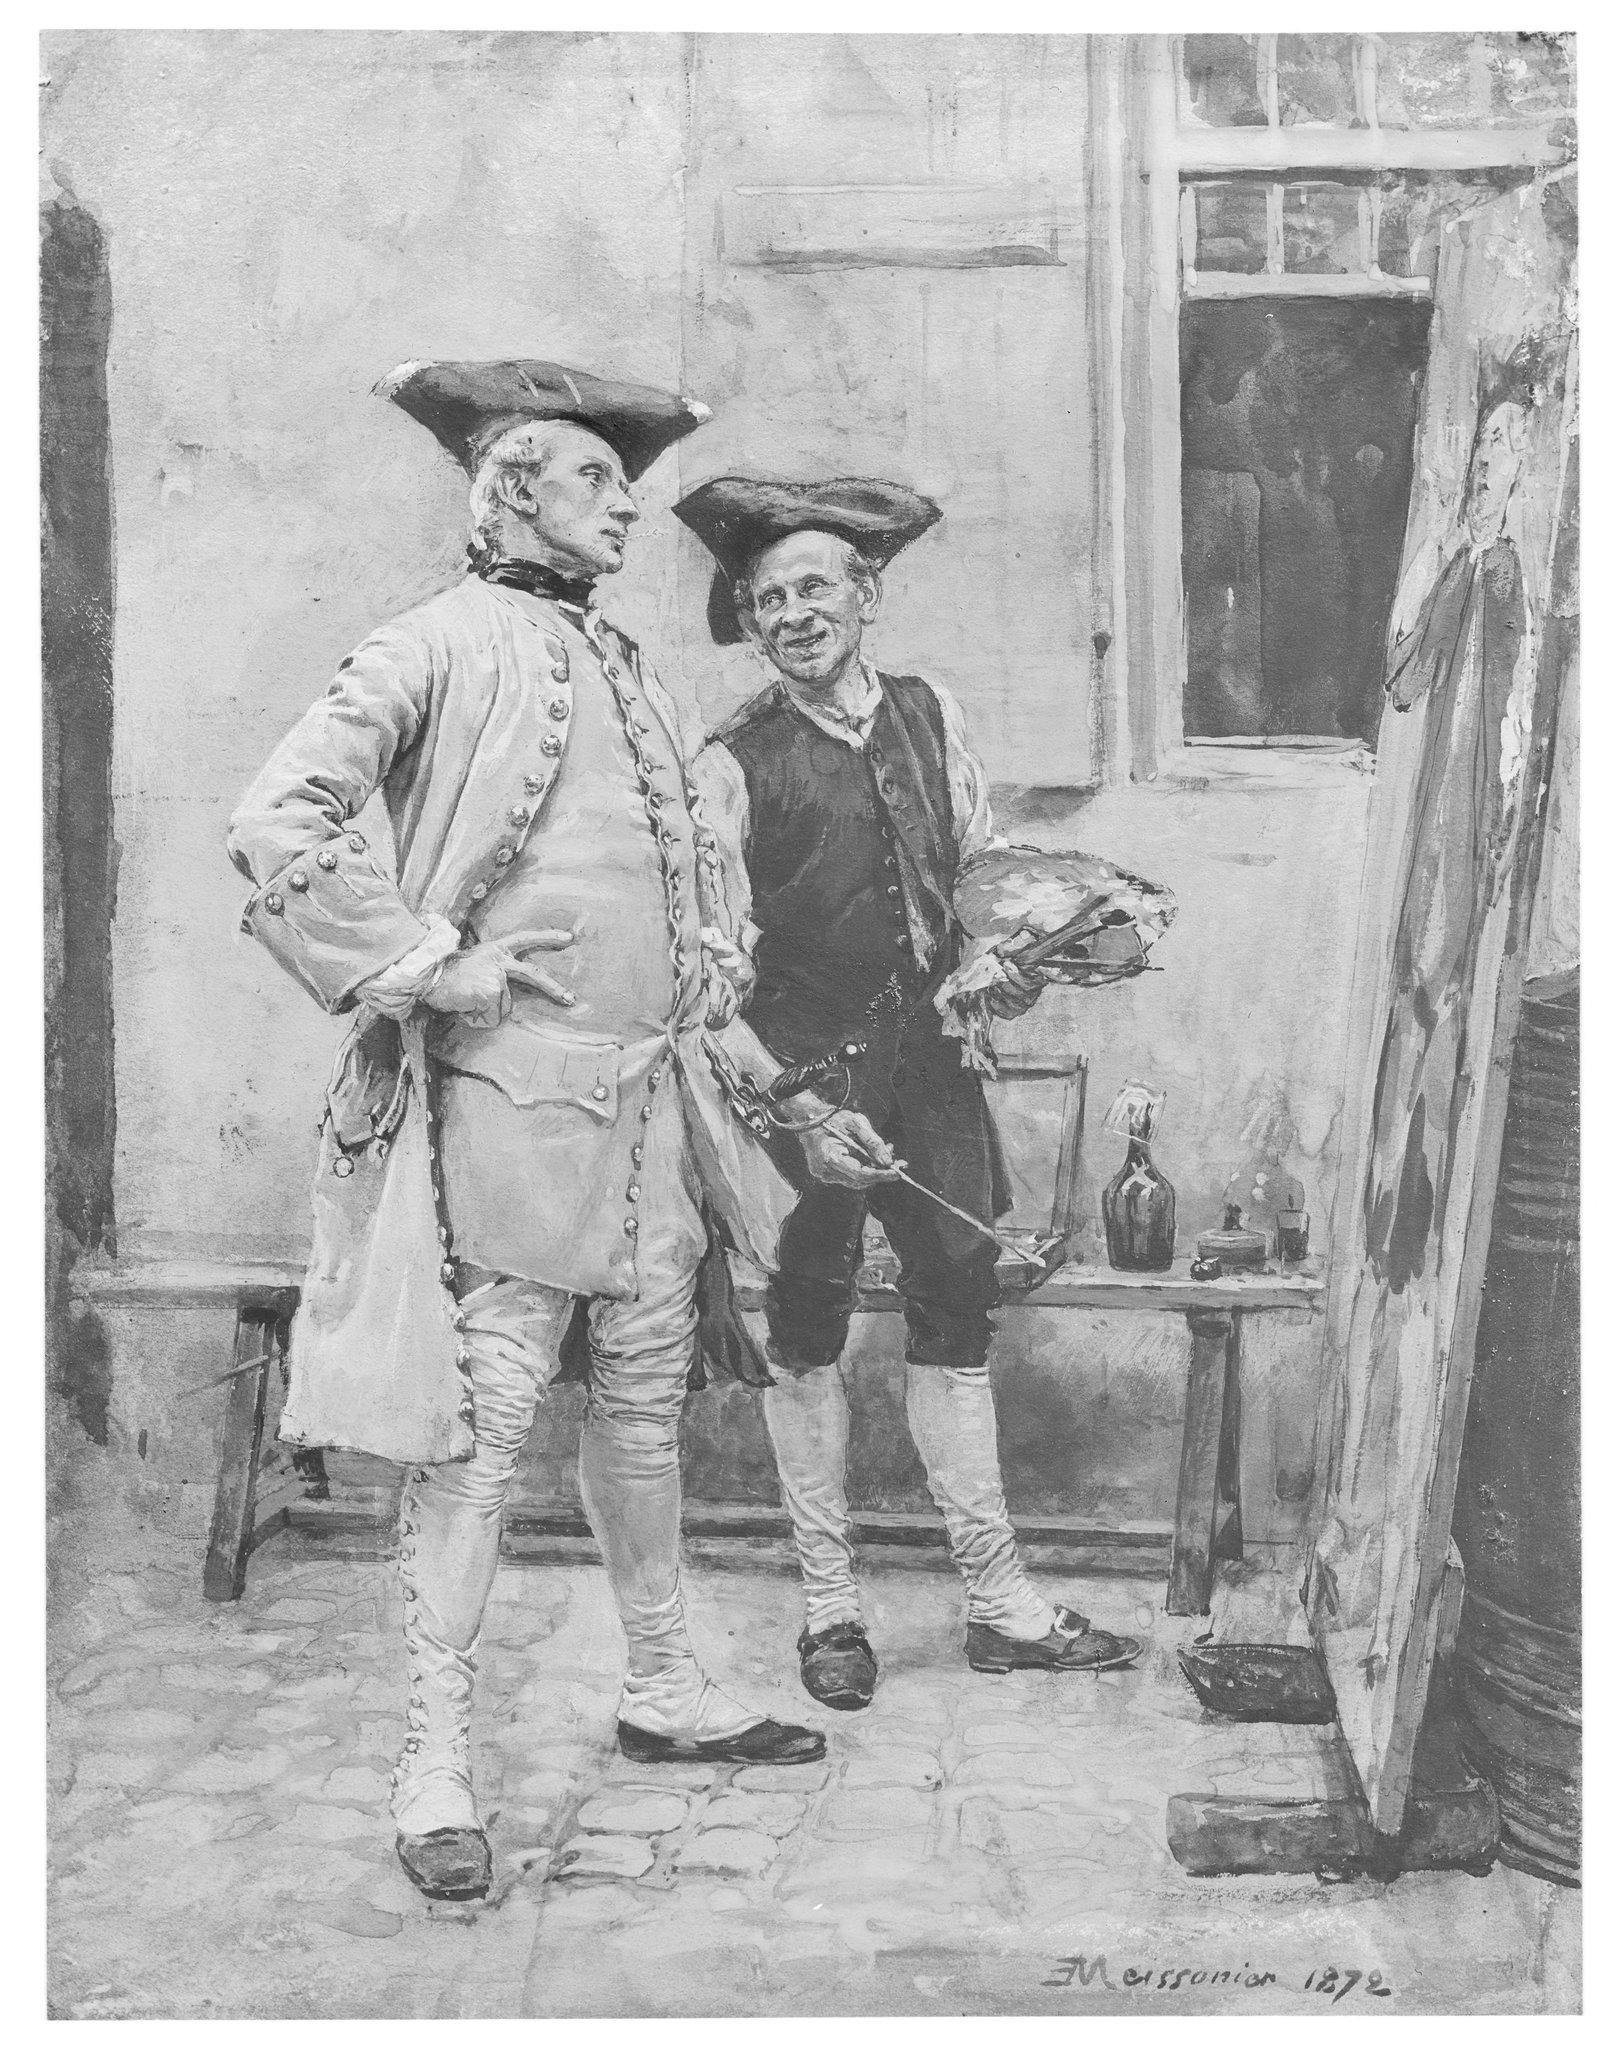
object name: drawing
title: The Sign Painter (Le Peintre d'Enseignes)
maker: ernest meissonier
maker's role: artist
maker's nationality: french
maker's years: 1815-1891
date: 1872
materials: watercolor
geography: france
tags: painting,men